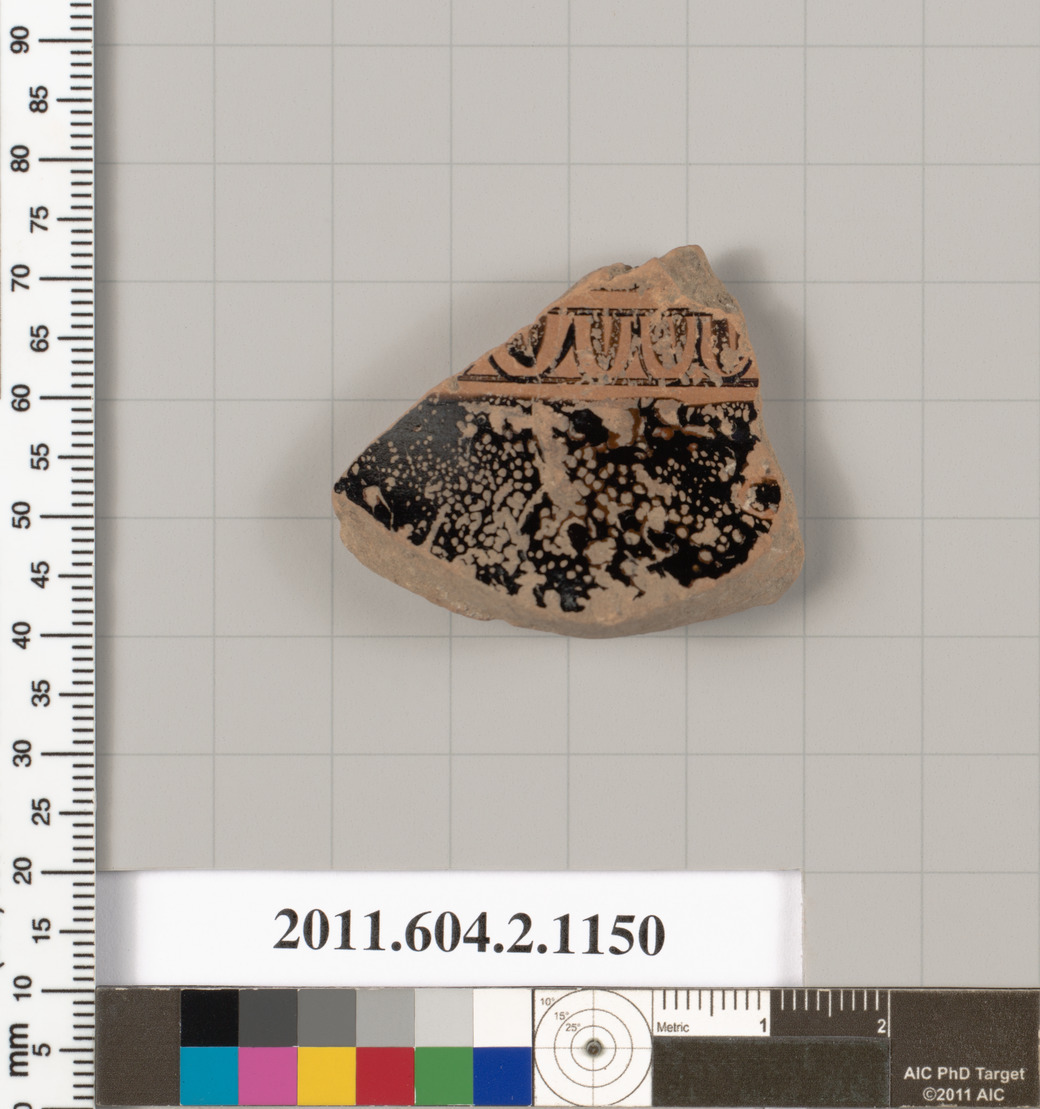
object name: chou fragment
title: Terracotta fragment of an oinochoe: chous (jug)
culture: greek, attic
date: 450-426 BCE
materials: terracotta